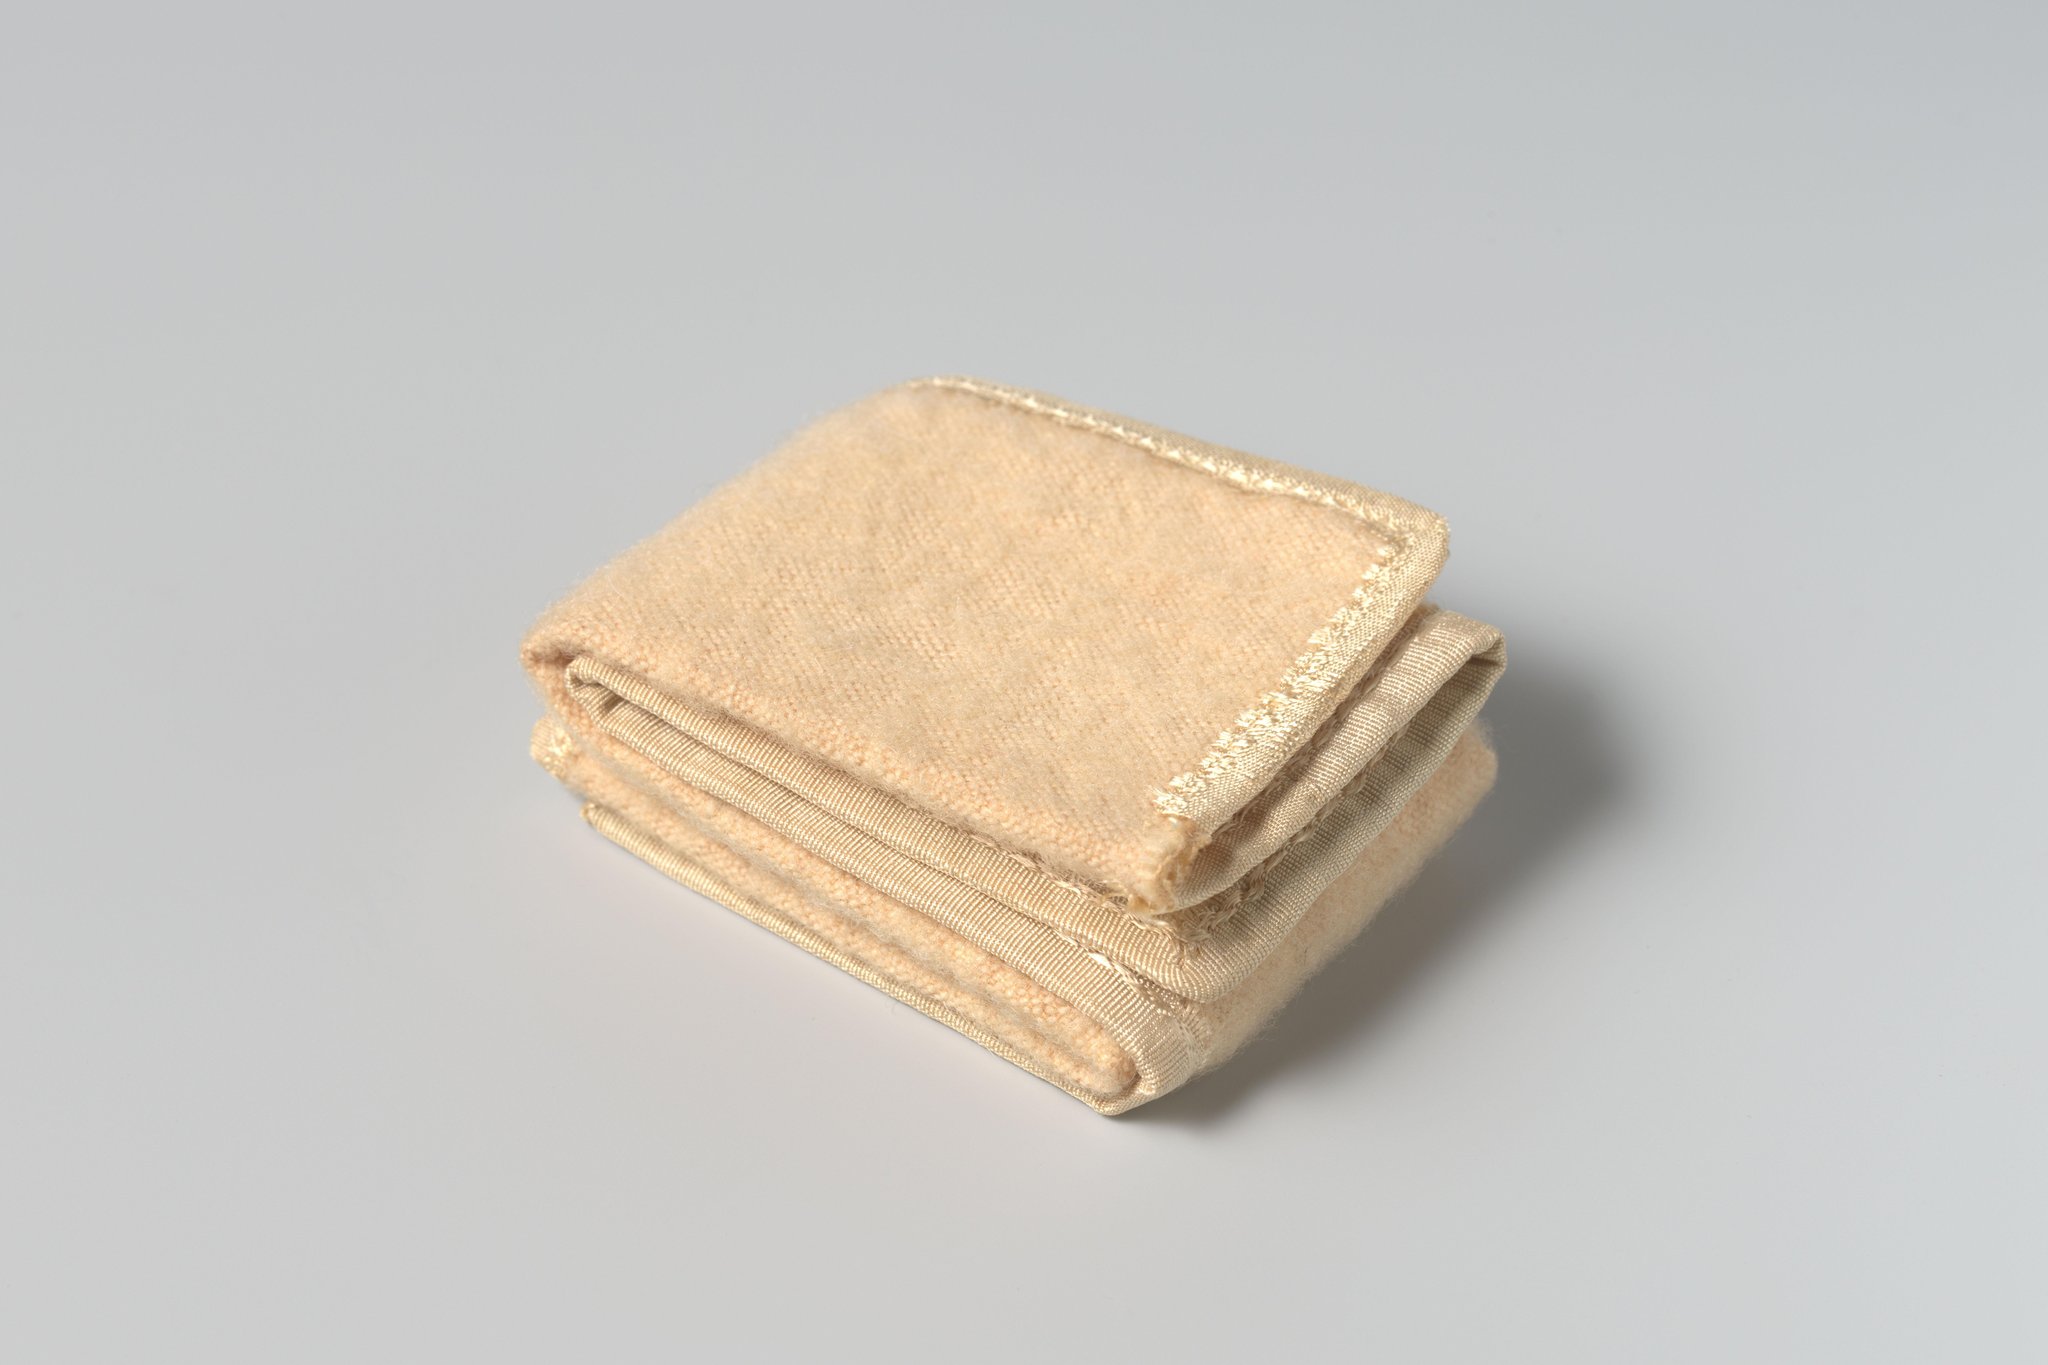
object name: blanket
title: Deken van witte wol, afgezet met blauwe zijden band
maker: Anonymous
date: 1676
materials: silk, wool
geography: amsterdam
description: Deken van witte geruwde wol, afgezet met blauwe zijden band met zigzag-patroon en lussen.